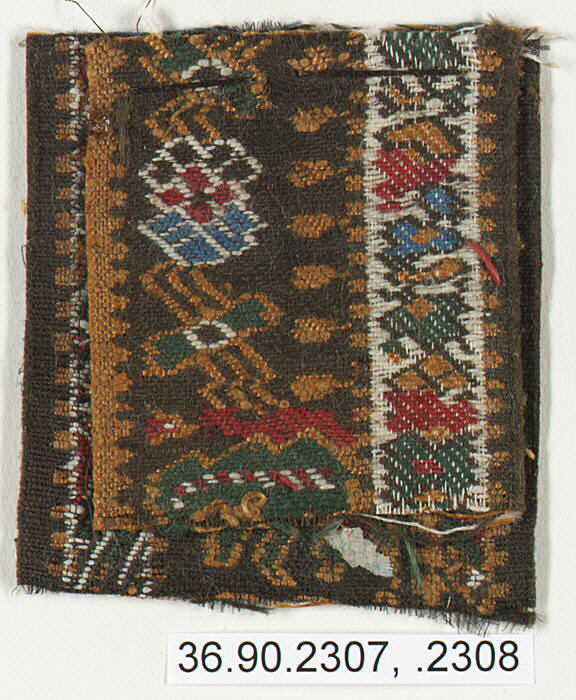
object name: border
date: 1801-1900